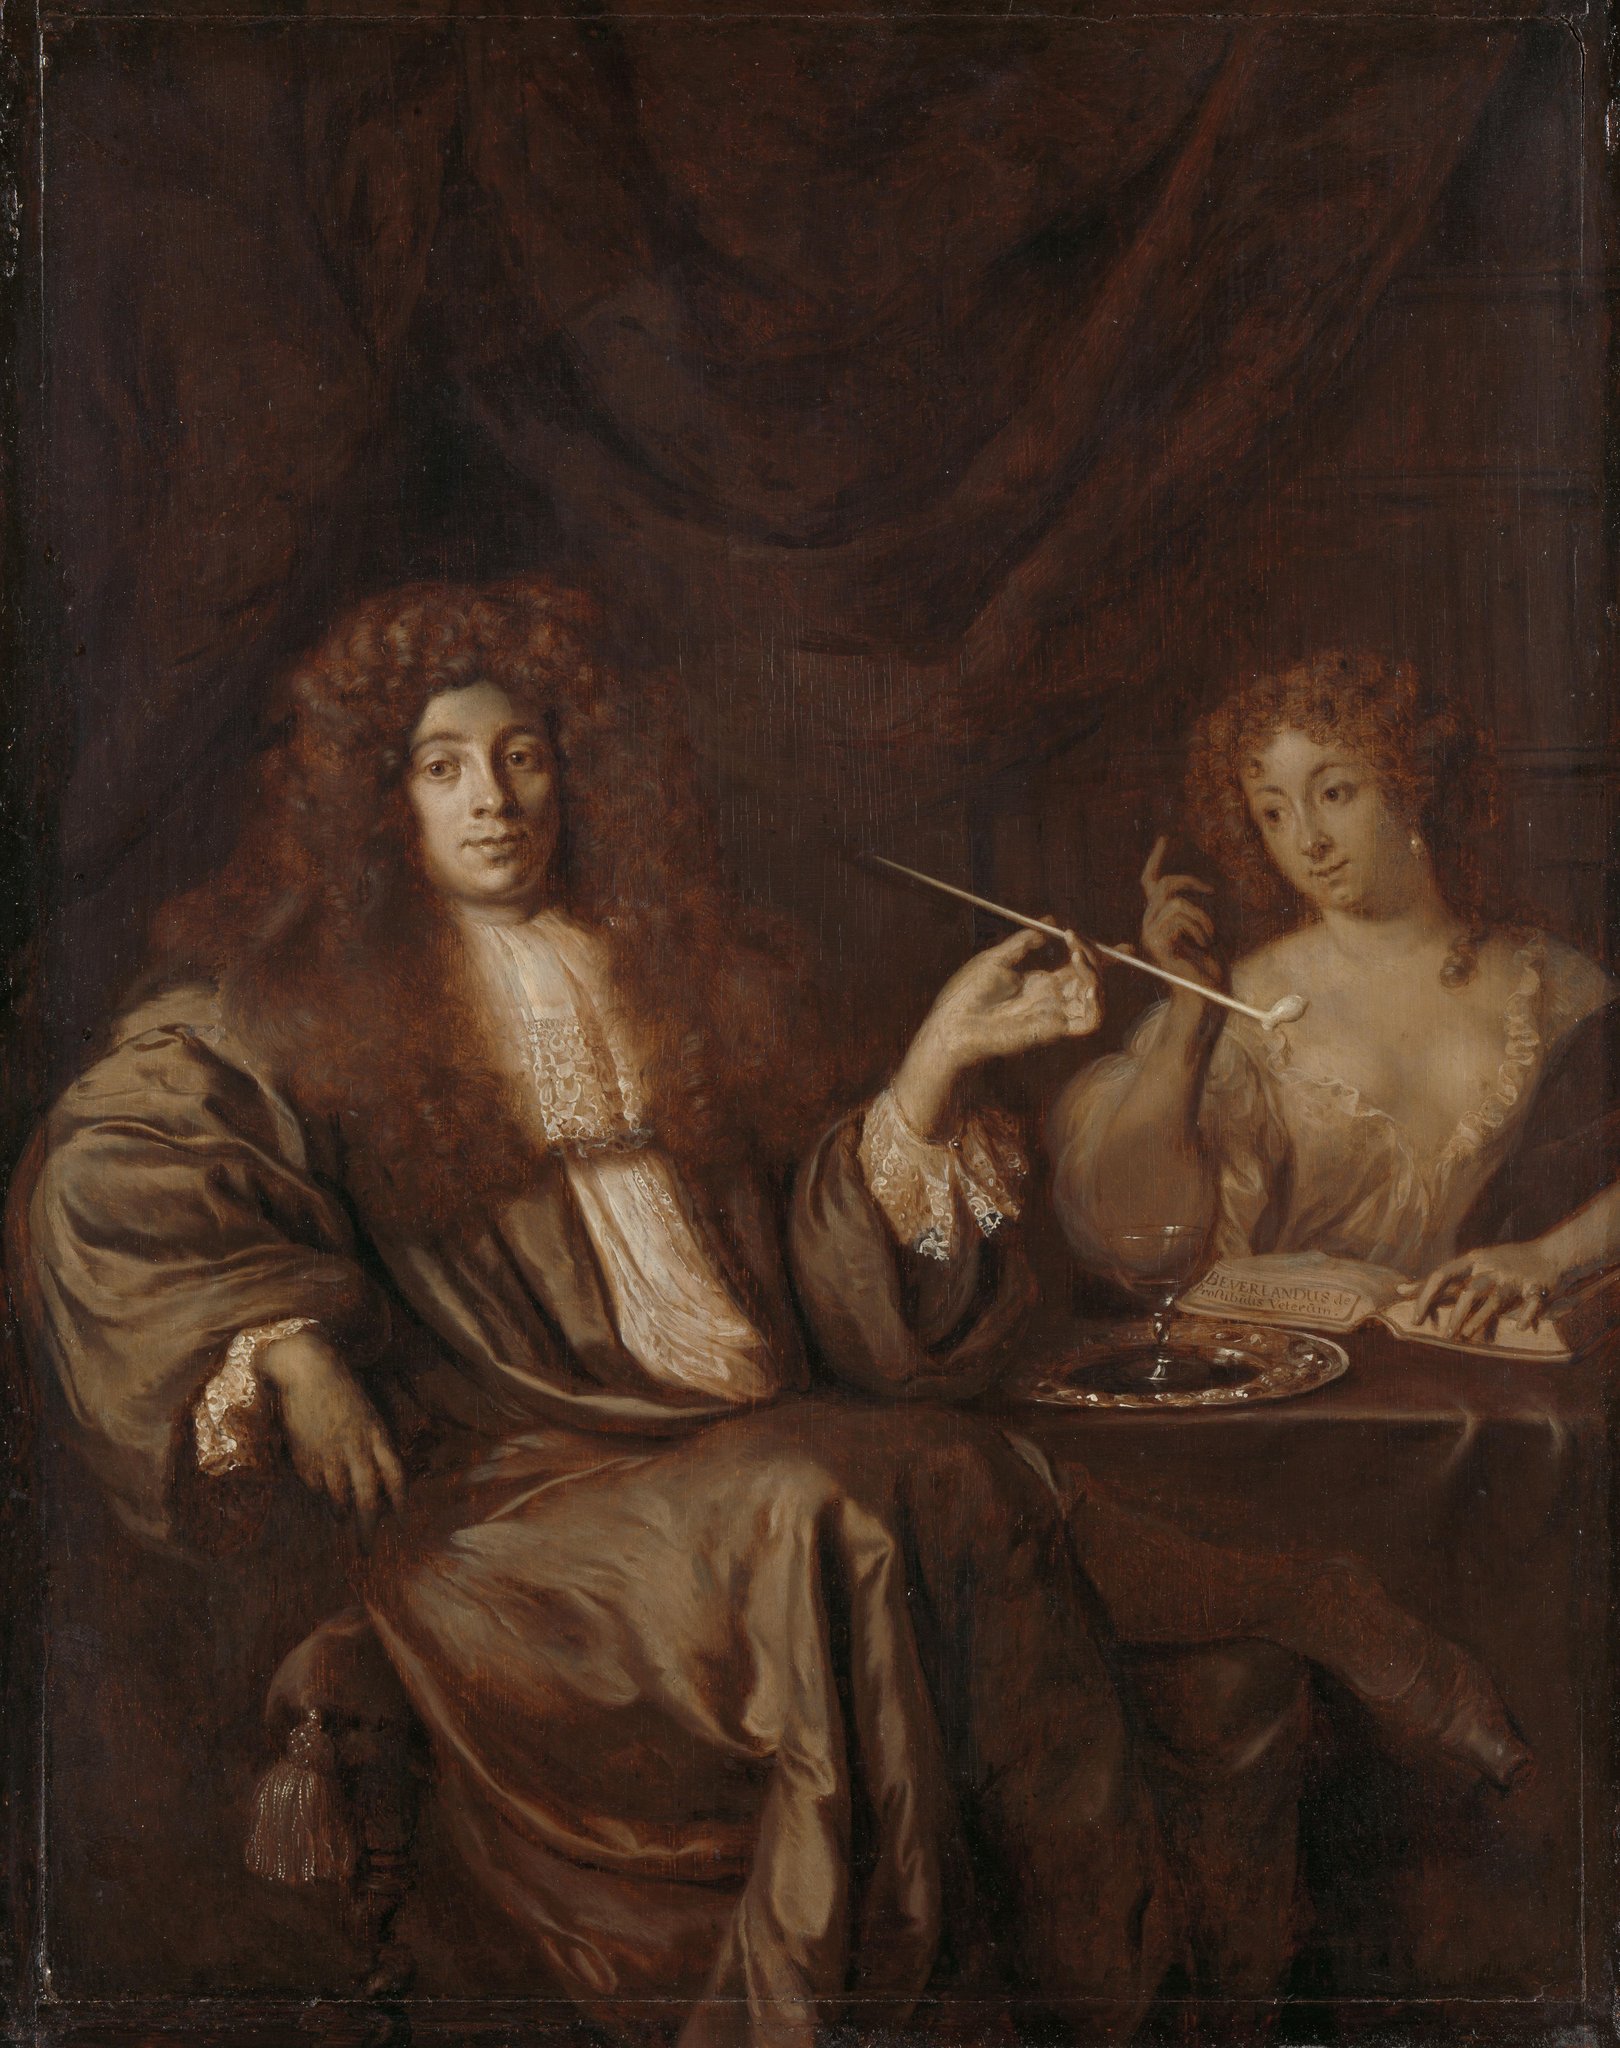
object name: painting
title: Hadriaan Beverland, Writer of Theological Works and Satirist, with a Prostitute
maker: ary de vois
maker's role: painter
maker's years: 1632-1680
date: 1676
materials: oil, panel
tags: london, historical persons, pipe ~ tobacco, portrait of a writer, prostitution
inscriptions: inscription: ‘Beverlandus de Prostibulis Veterum’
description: This striking panel painting shows the eccentric Beverland with a wine glass and a pipe. Sitting next to him is a prostitute. This portrayal was a deliberate provocation. Done in various shades of brown (the so-called brunaille technique), the painting is a preparatory study for the frontispiece of Beverland’s planned edition of erotic texts, De prostibulis veterum (On the brothels of the ancients). Even though it never appeared in print, this ‘book’ lies open on the table!